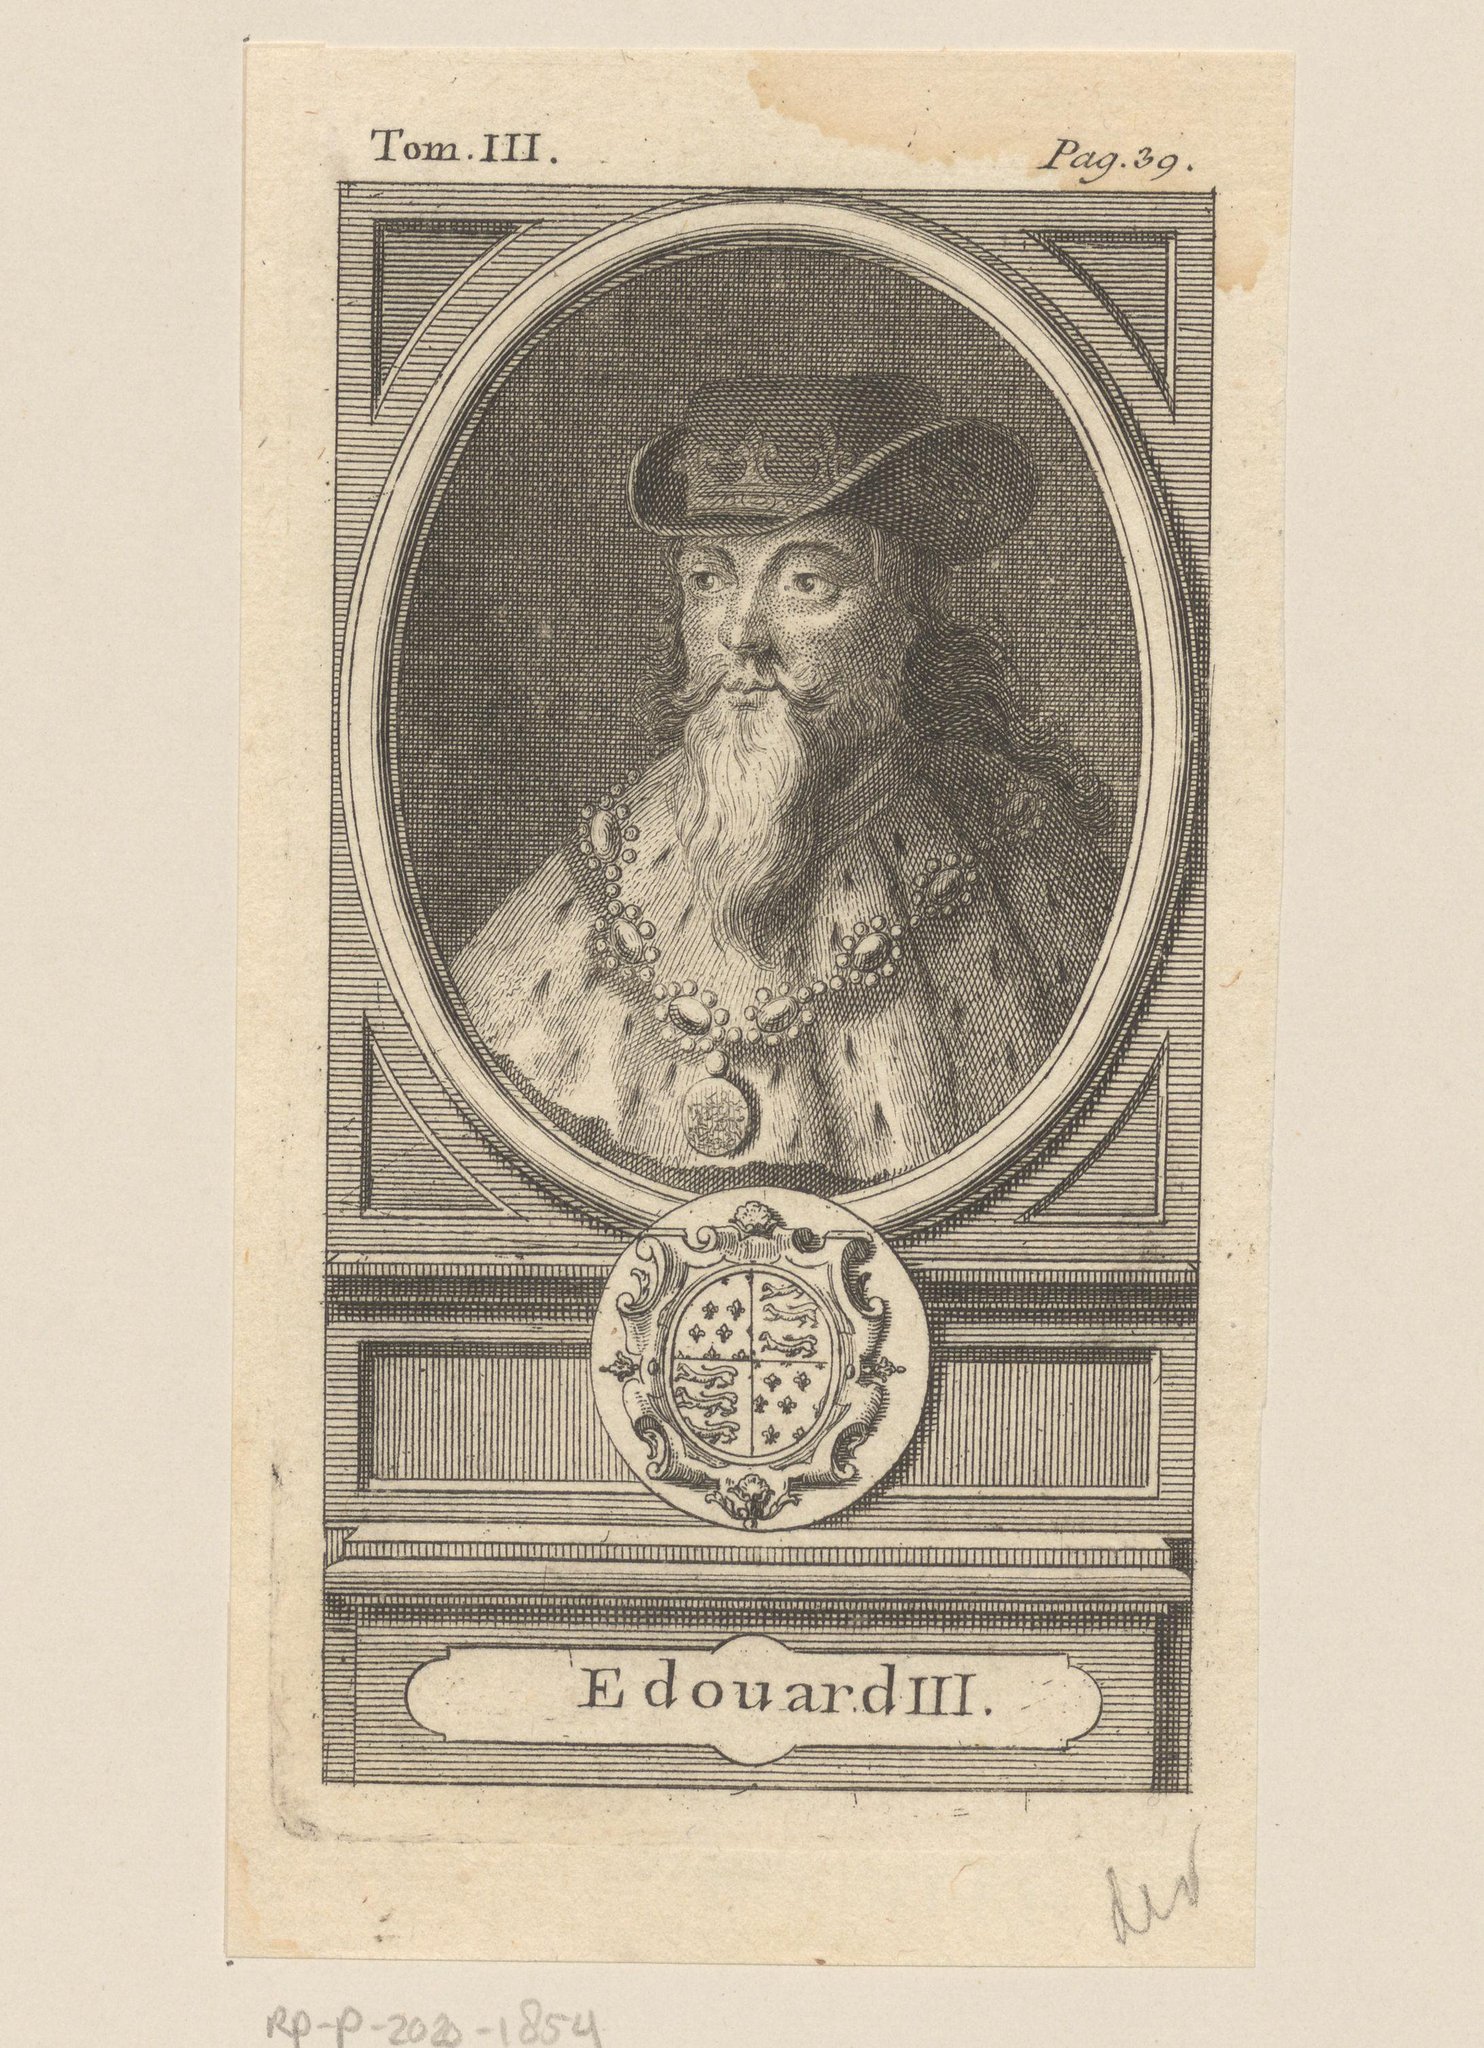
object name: print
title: Portret van Eduard III van Engeland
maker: Anonymous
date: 1750-1762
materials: paper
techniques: etching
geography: france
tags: crown (symbol of sovereignty), historical persons, king, armorial bearing, heraldry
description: Prent gebruikt in: Orleans, Pierre Joseph d’. Histoire des revolutions d'Angleterre, depuis le commencement de la monarchie. Parijs: Pierre-François Giffart en Jacques Rolin, 1750. Prent ook gebruikt in de 1762-editie uitgegeven in Lyon door de gebroeders Duplain. Mogelijk ook gebruikt in andere edities of andere publicaties.